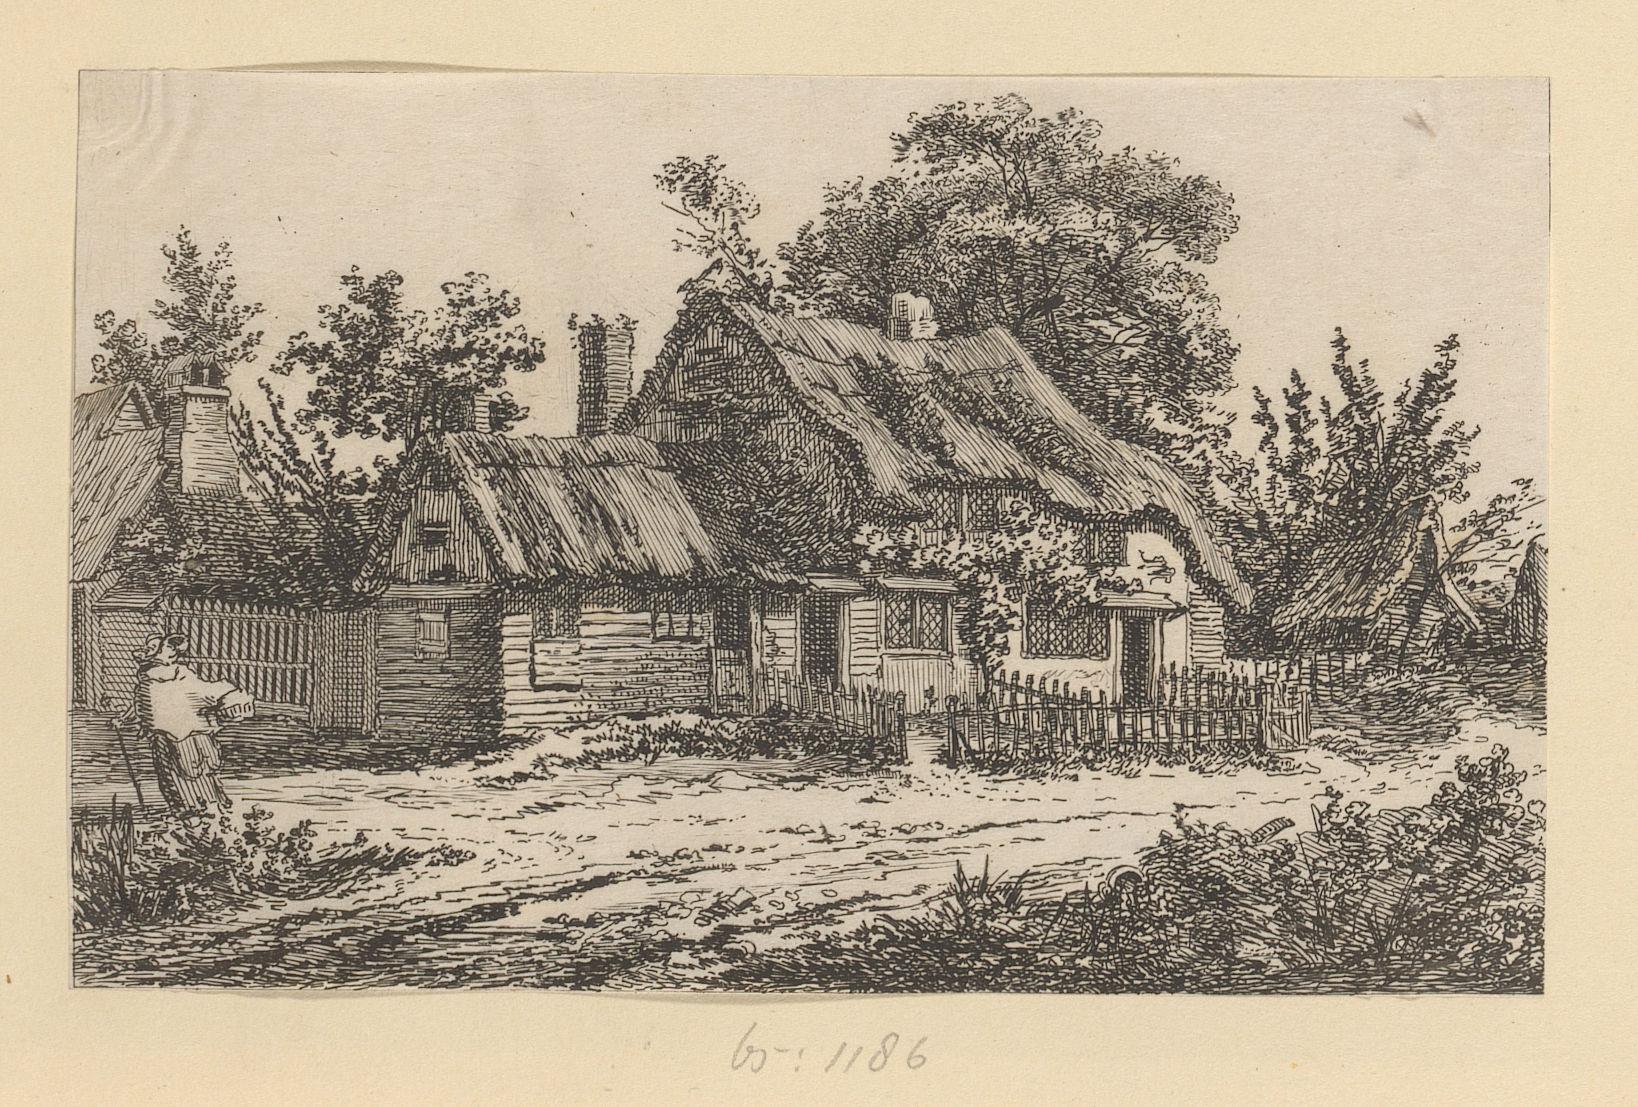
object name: album leaf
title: Boerderij aan een landweg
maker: john thomas smith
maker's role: painter, print maker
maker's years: 1766-1833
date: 1776-1833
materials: paper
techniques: etching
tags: landscapes (+ landscape with figures, staffage), farm (building)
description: Prent hoort mogelijk bij een serie getiteld 'Twenty rural landscapes from nature' uit 1795, uitgegeven door Nathaniel Smith. Prent maakt mogelijk deel uit van een serie van 200 prenten. Deze serie is onder de titel 'A Collection of two hundred original etchings' voor het eerst uitgegeven door J.M. Greery in 1816.